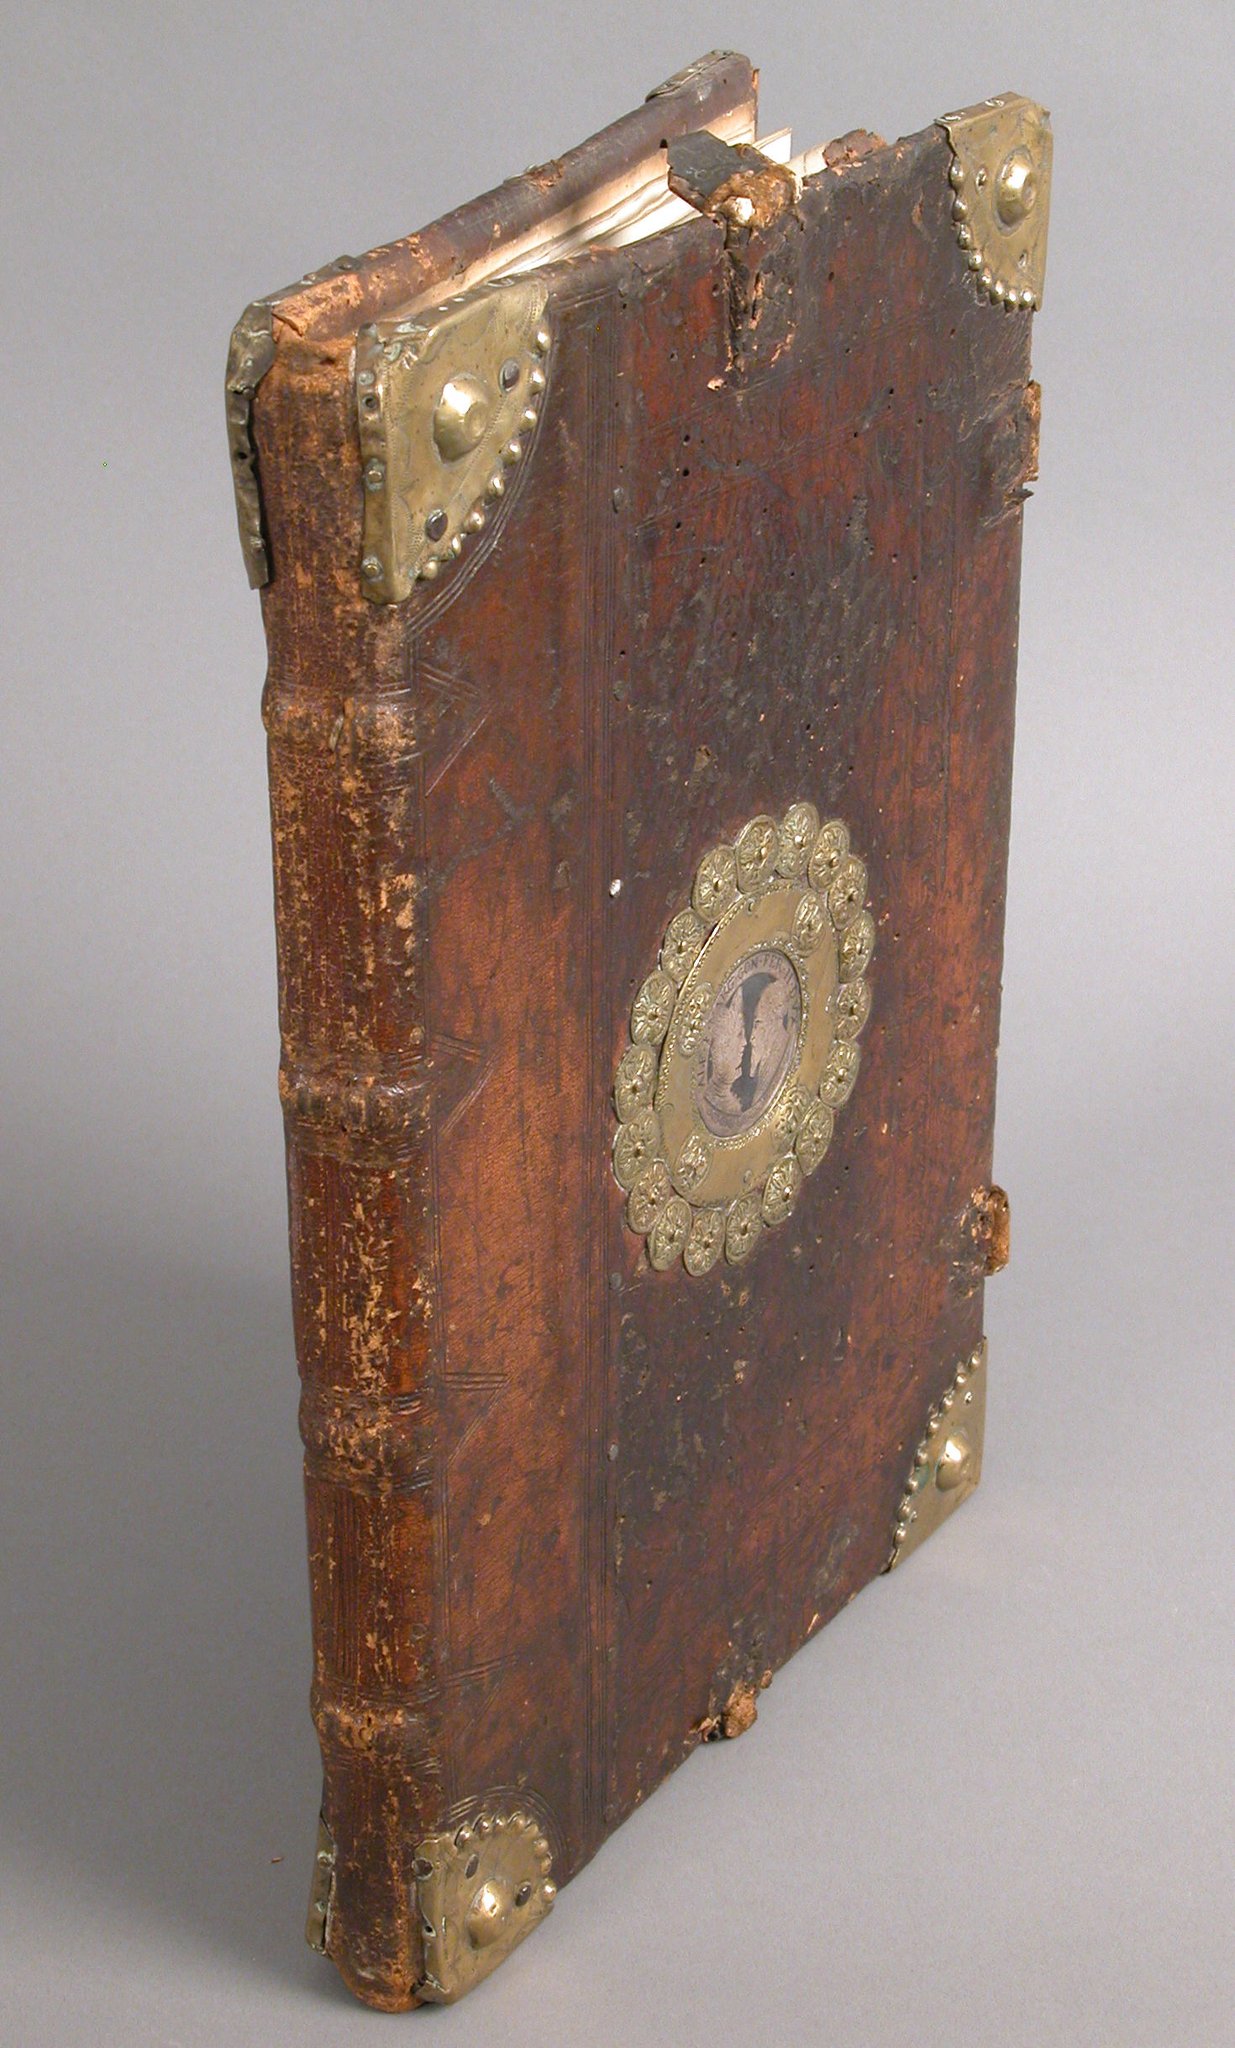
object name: antiphonary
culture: spanish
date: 1401-1600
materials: gold, ink, leather, paper, paint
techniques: bookbinding